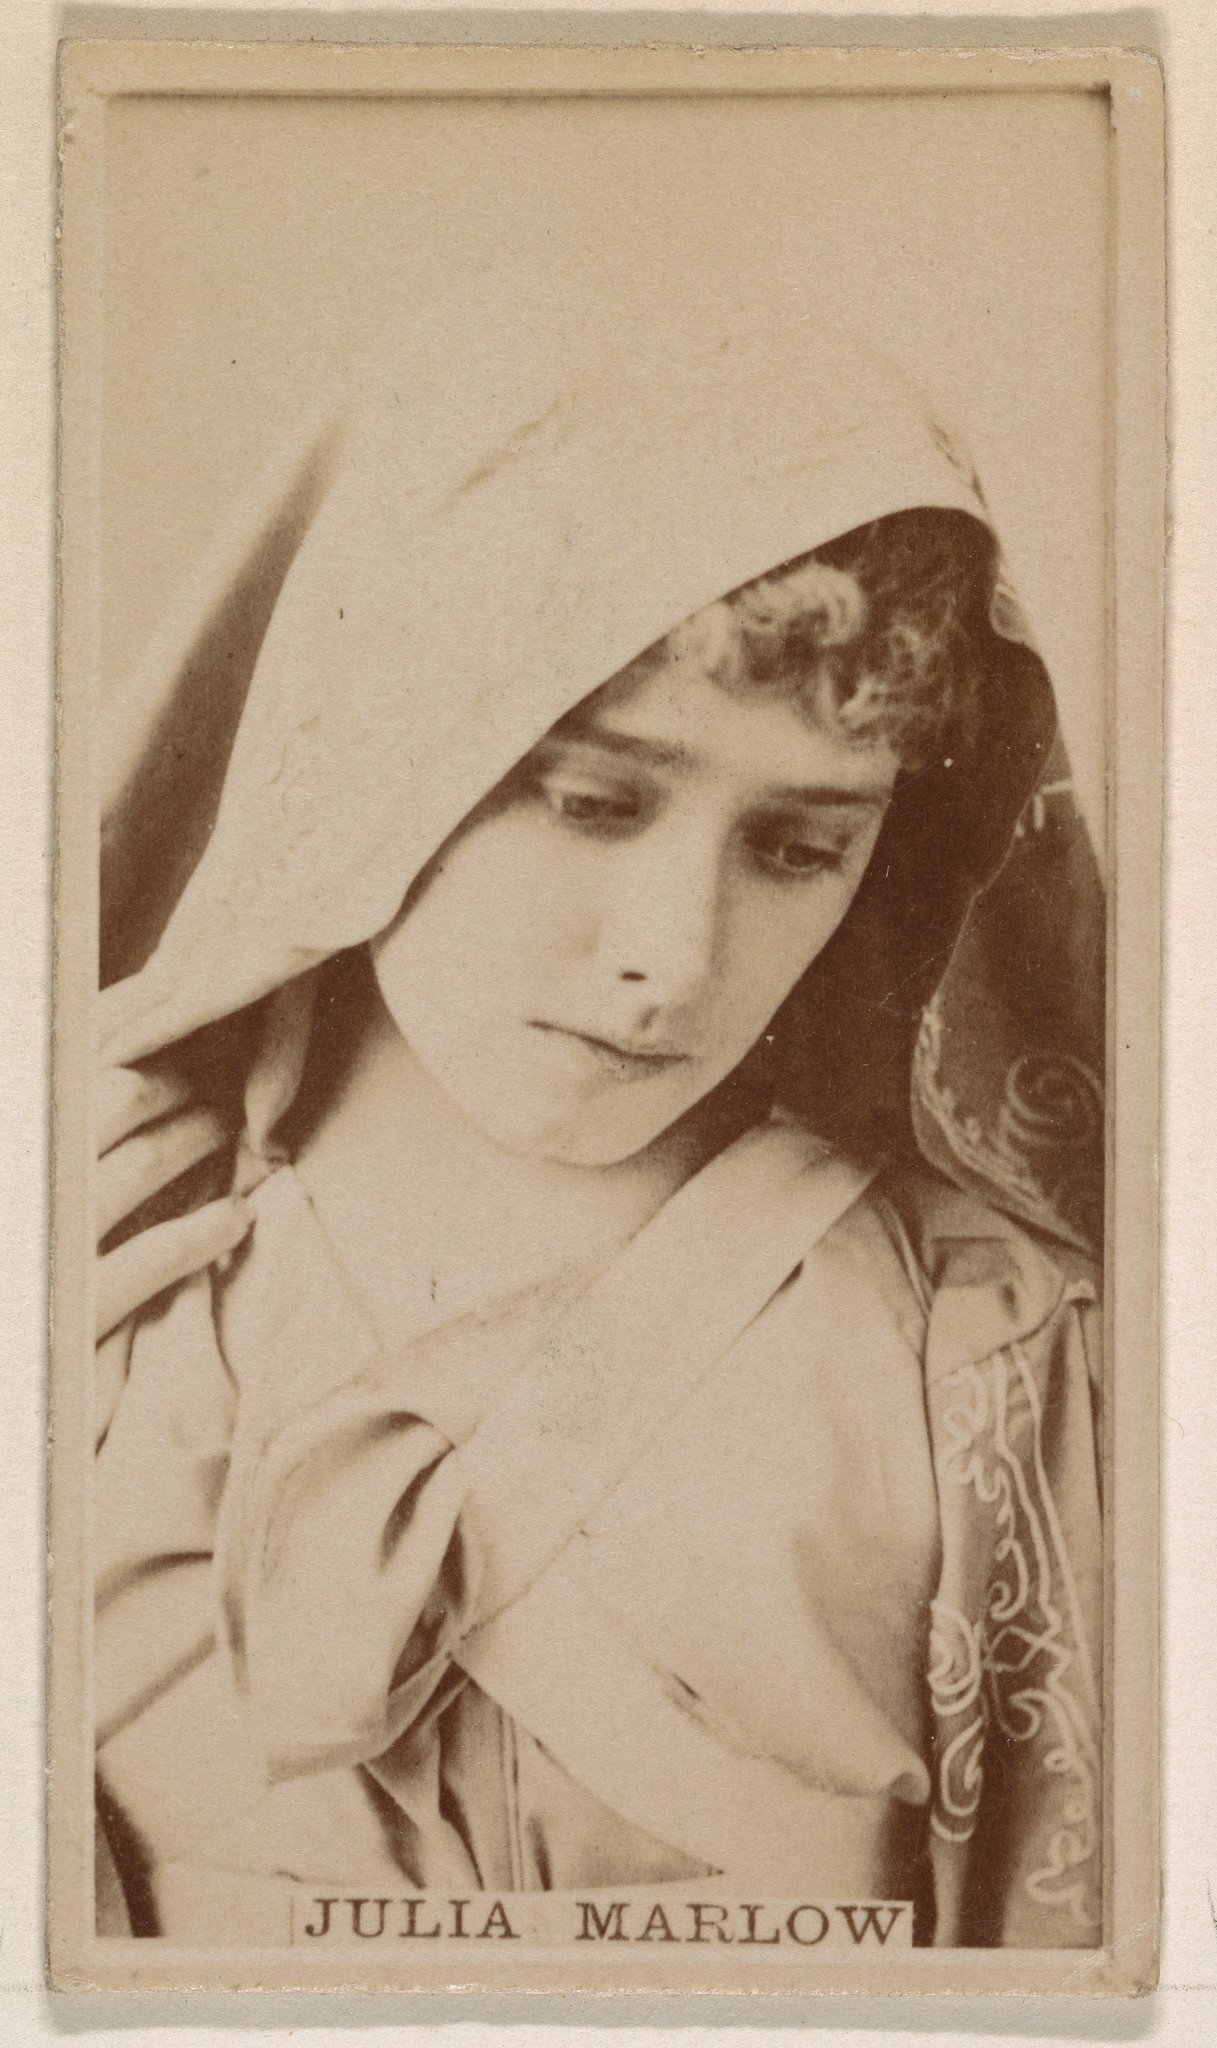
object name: photograph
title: Julia Marlow, from the Actresses series (N245) issued by Kinney Brothers to promote Sweet Caporal Cigarettes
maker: kinney brothers tobacco company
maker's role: publisher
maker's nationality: american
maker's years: 1869-2011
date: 1890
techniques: albumen silver print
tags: portraits,women,actresses